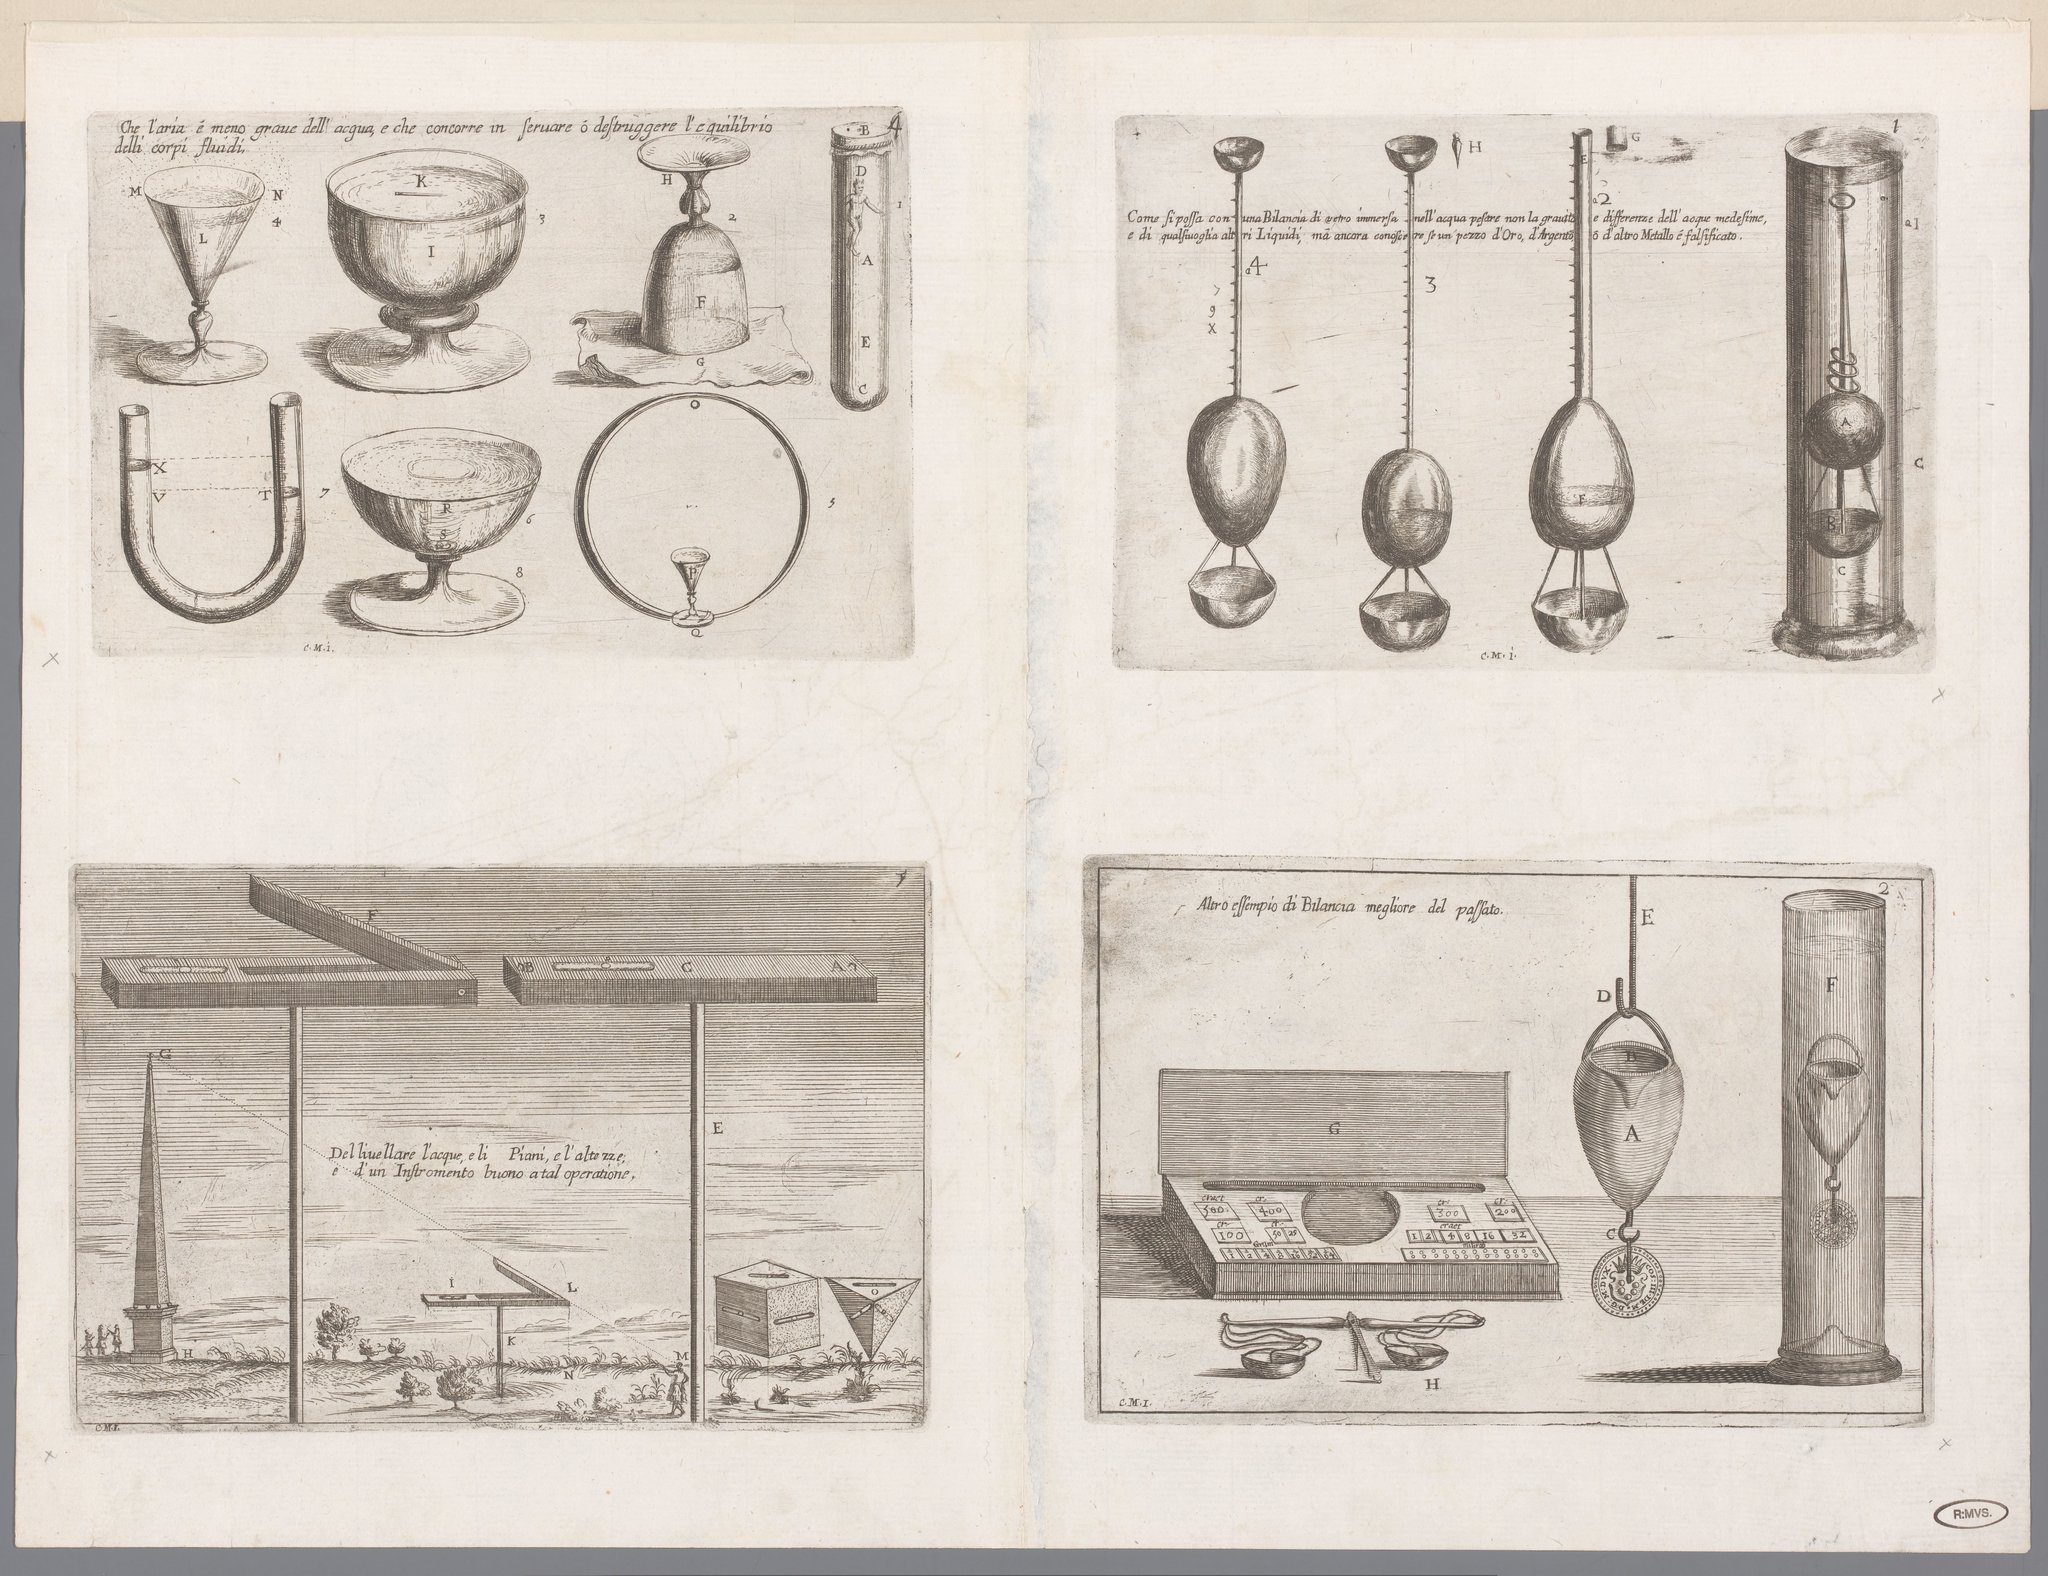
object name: print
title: Vier schematische weergaves ter verduidelijking van wetenschappelijke theorieën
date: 1678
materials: paper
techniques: etching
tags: education, science and learning, scales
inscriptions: collector's mark: Lugt 2228